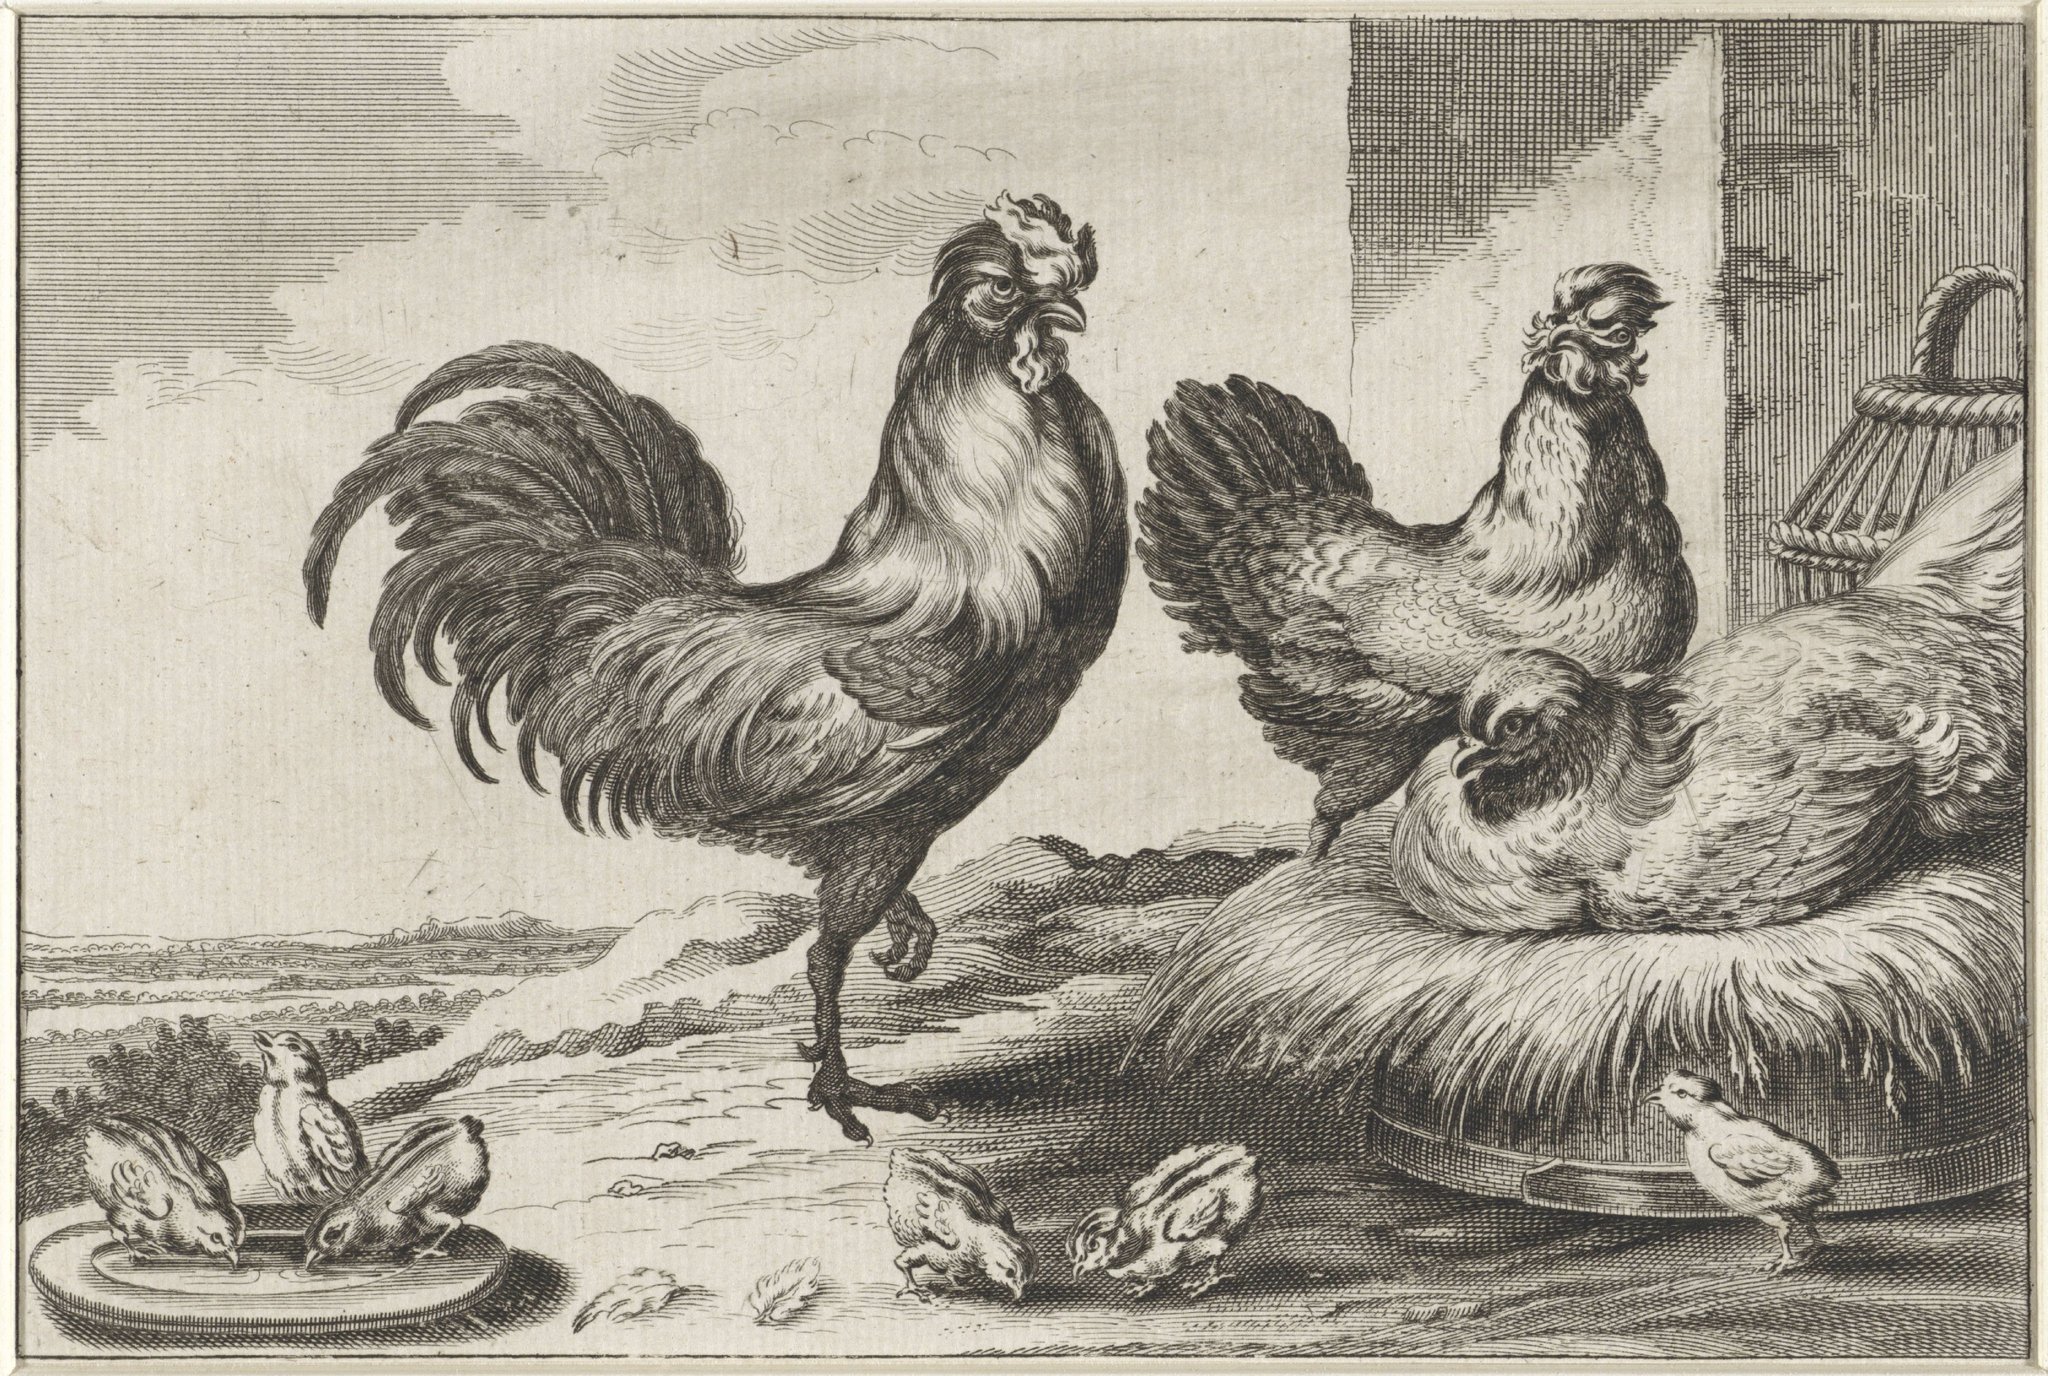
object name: print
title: Verschillende vogels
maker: Anonymous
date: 1654-1712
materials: paper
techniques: etching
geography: london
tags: fowl (cock, hen, chicken, etc.)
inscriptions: collector's mark: Lugt 240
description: Kopie naar prent die deel uitmaakt van de negendelige serie met voorstellingen van verschillende vogels: "Diversae avium species".